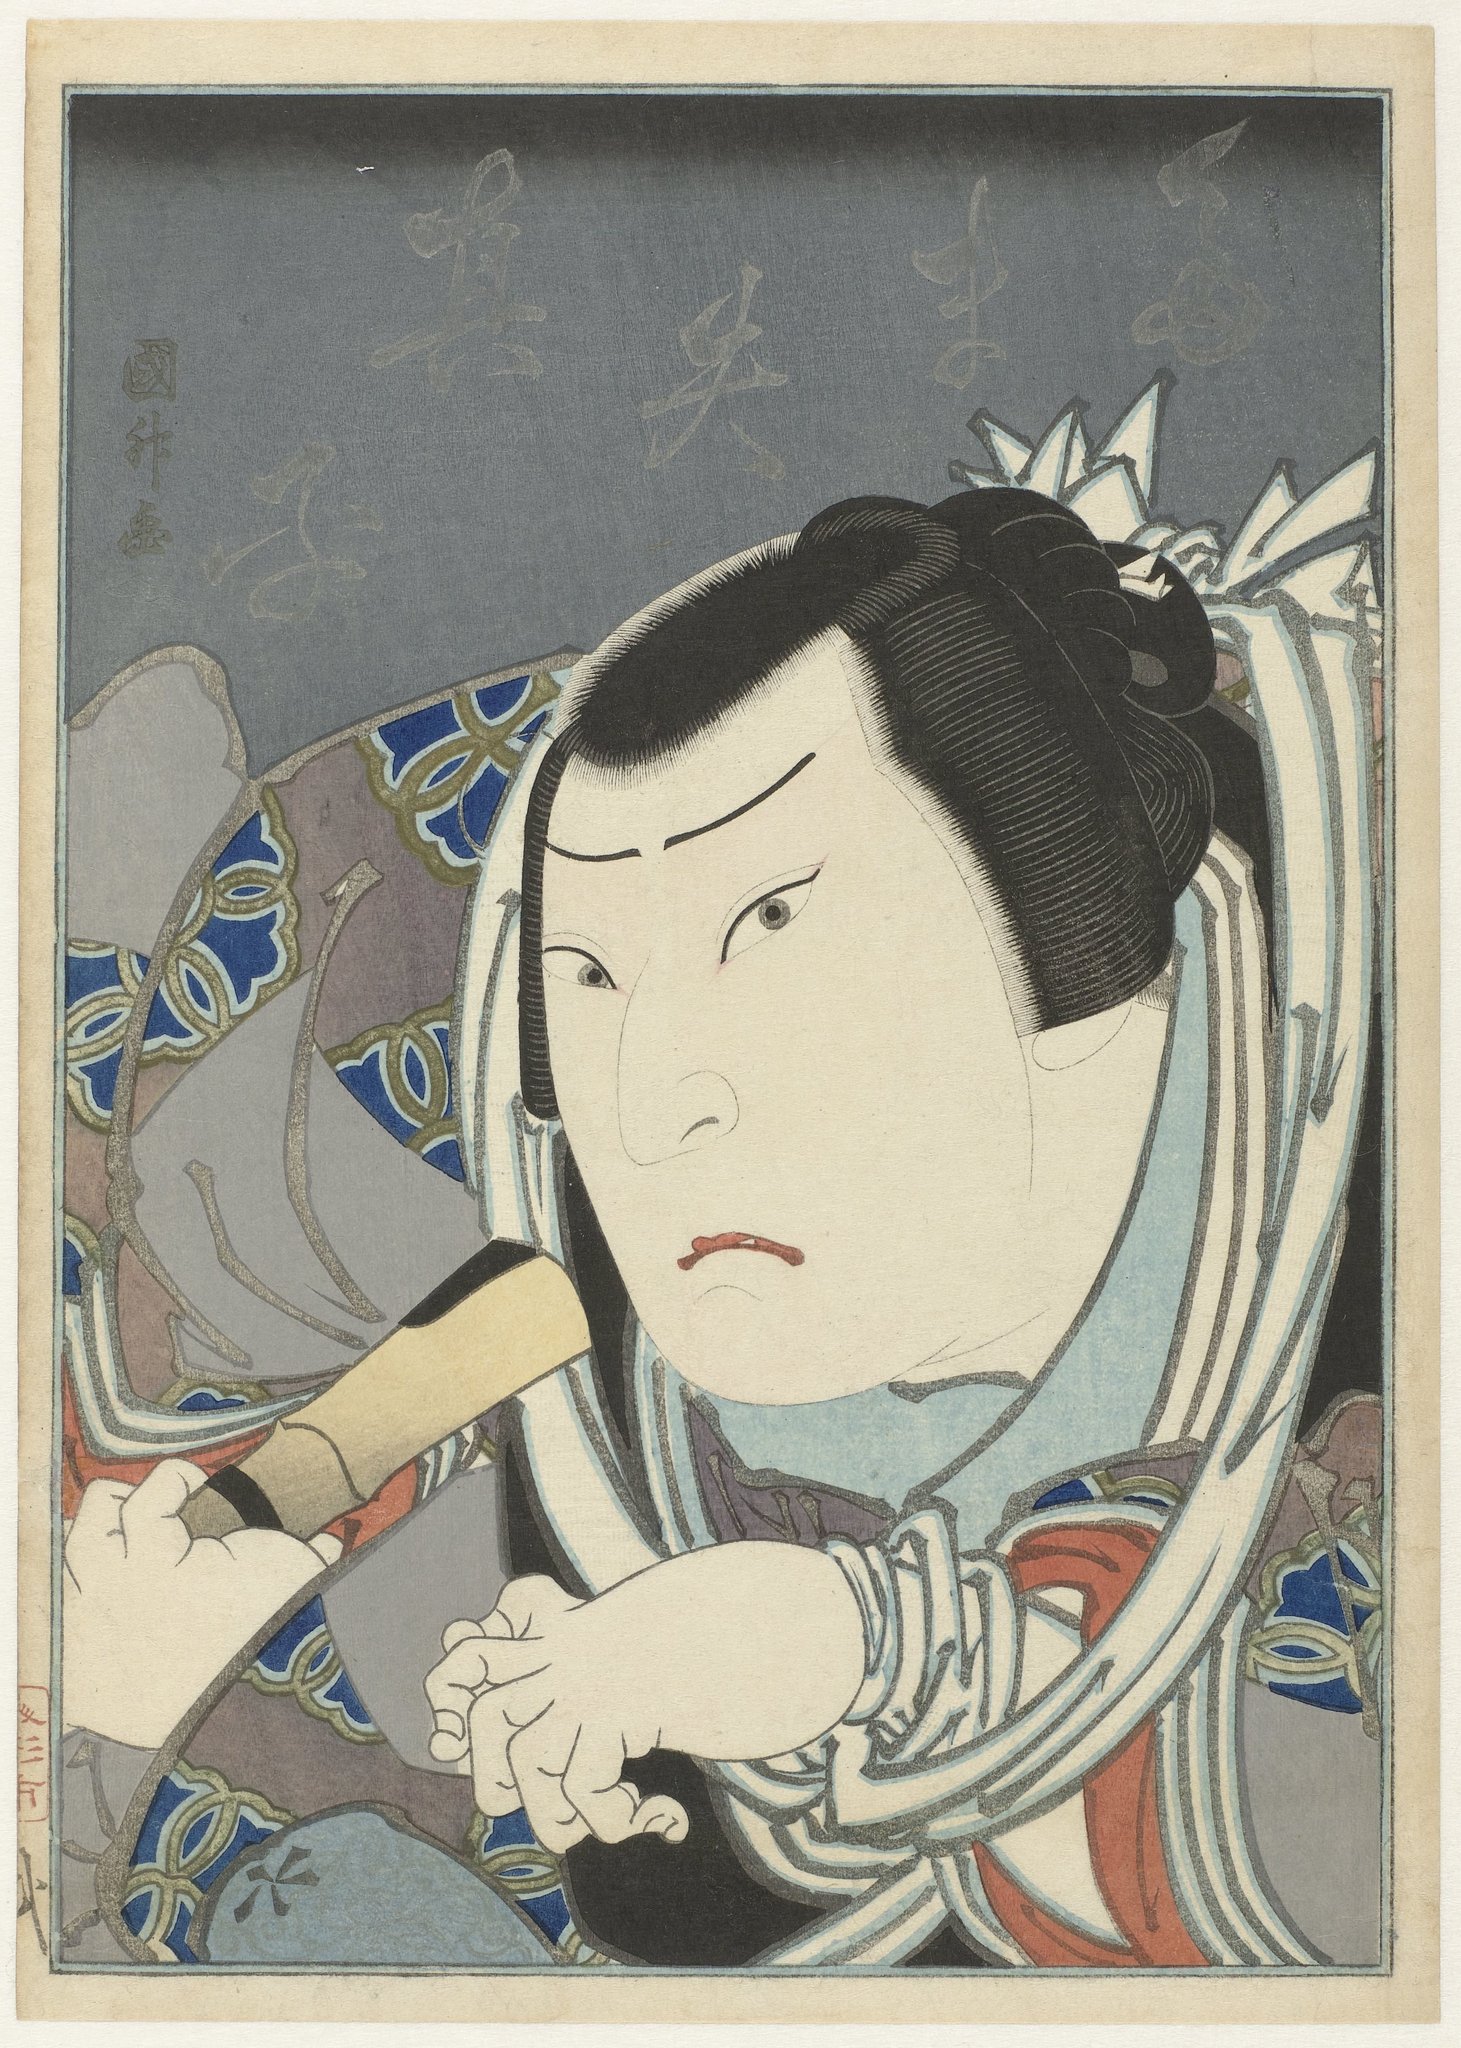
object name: print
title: Onoe Tamizô II als Tamaya Shinbei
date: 1849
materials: paper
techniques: woodcut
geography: osaka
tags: actor (on the stage), flute, aulos, tibia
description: Toneelspeler Onoe Tamizô II in de rol van Tamaya Shinbei met bamboe fluit in zijn hand. Scene uit het toneelstuk "Echizen mikuni fûfuzuka', opgevoerd in het Kado Theater, in de negende maand van 1849.